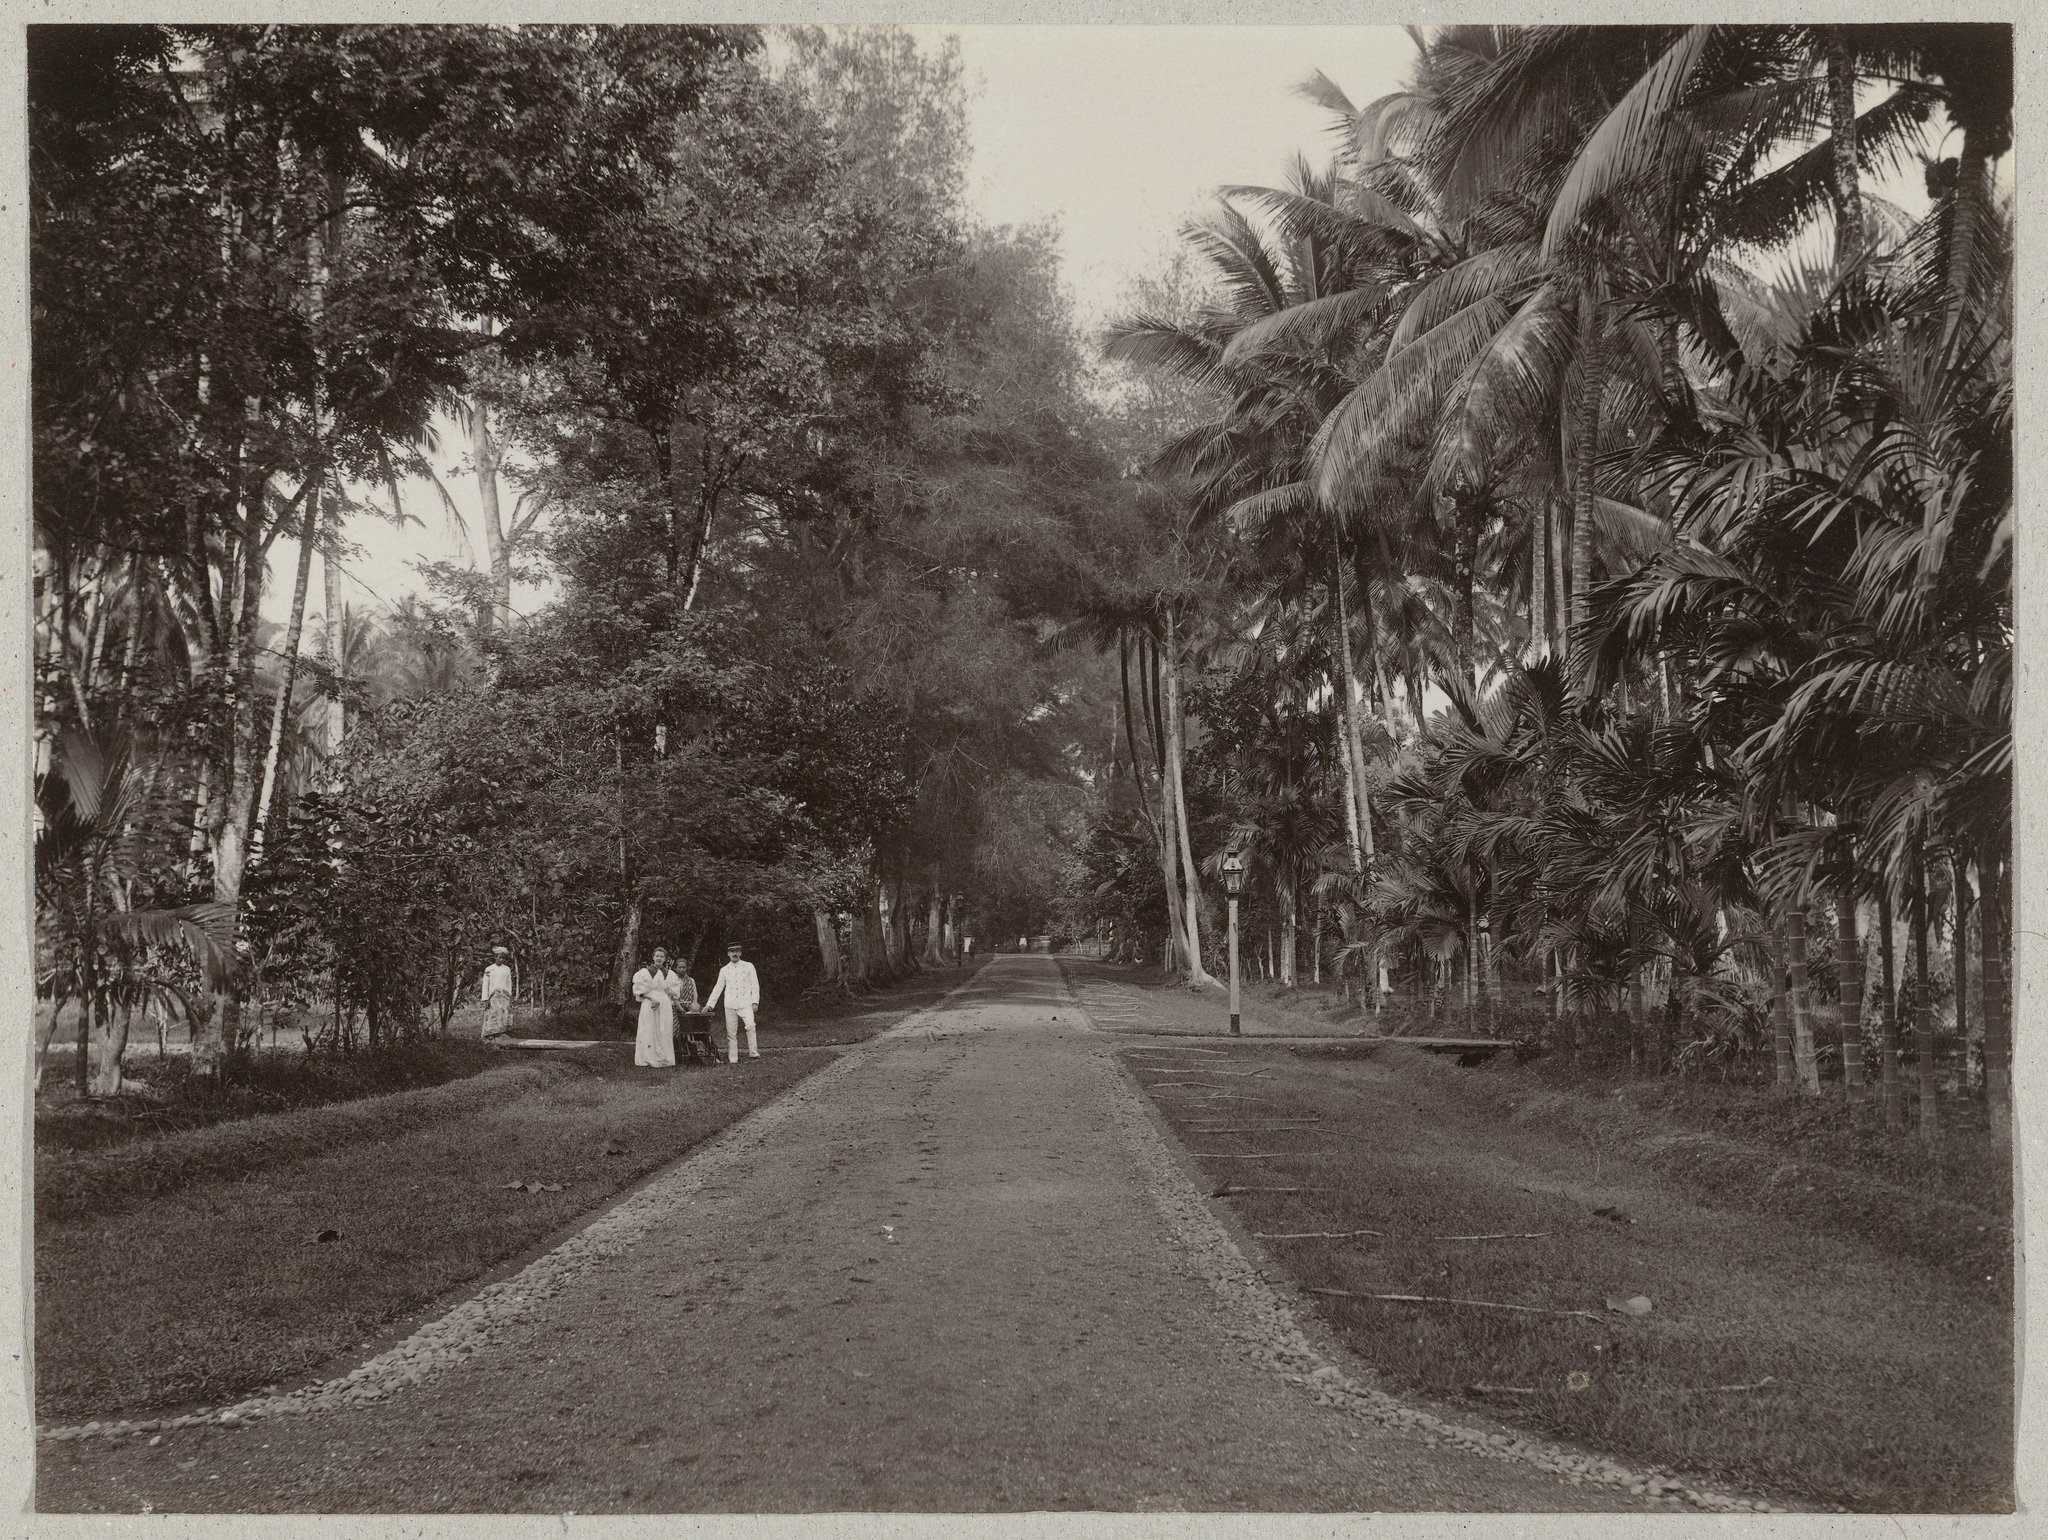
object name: photograph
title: Straatgezicht in Payakumbuh met langs de kant van de weg een onbekend echtpaar met baby, een baboe en bediende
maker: christiaan benjamin nieuwenhuis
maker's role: publisher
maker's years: 1863-1922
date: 1891-1912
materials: paper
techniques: albumen print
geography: payakumbuh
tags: baby-sitter, trees: palm-tree, house personnel, servants, street (+ city(-scape) with figures, staffage)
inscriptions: inscription: ‘Pajacombo’